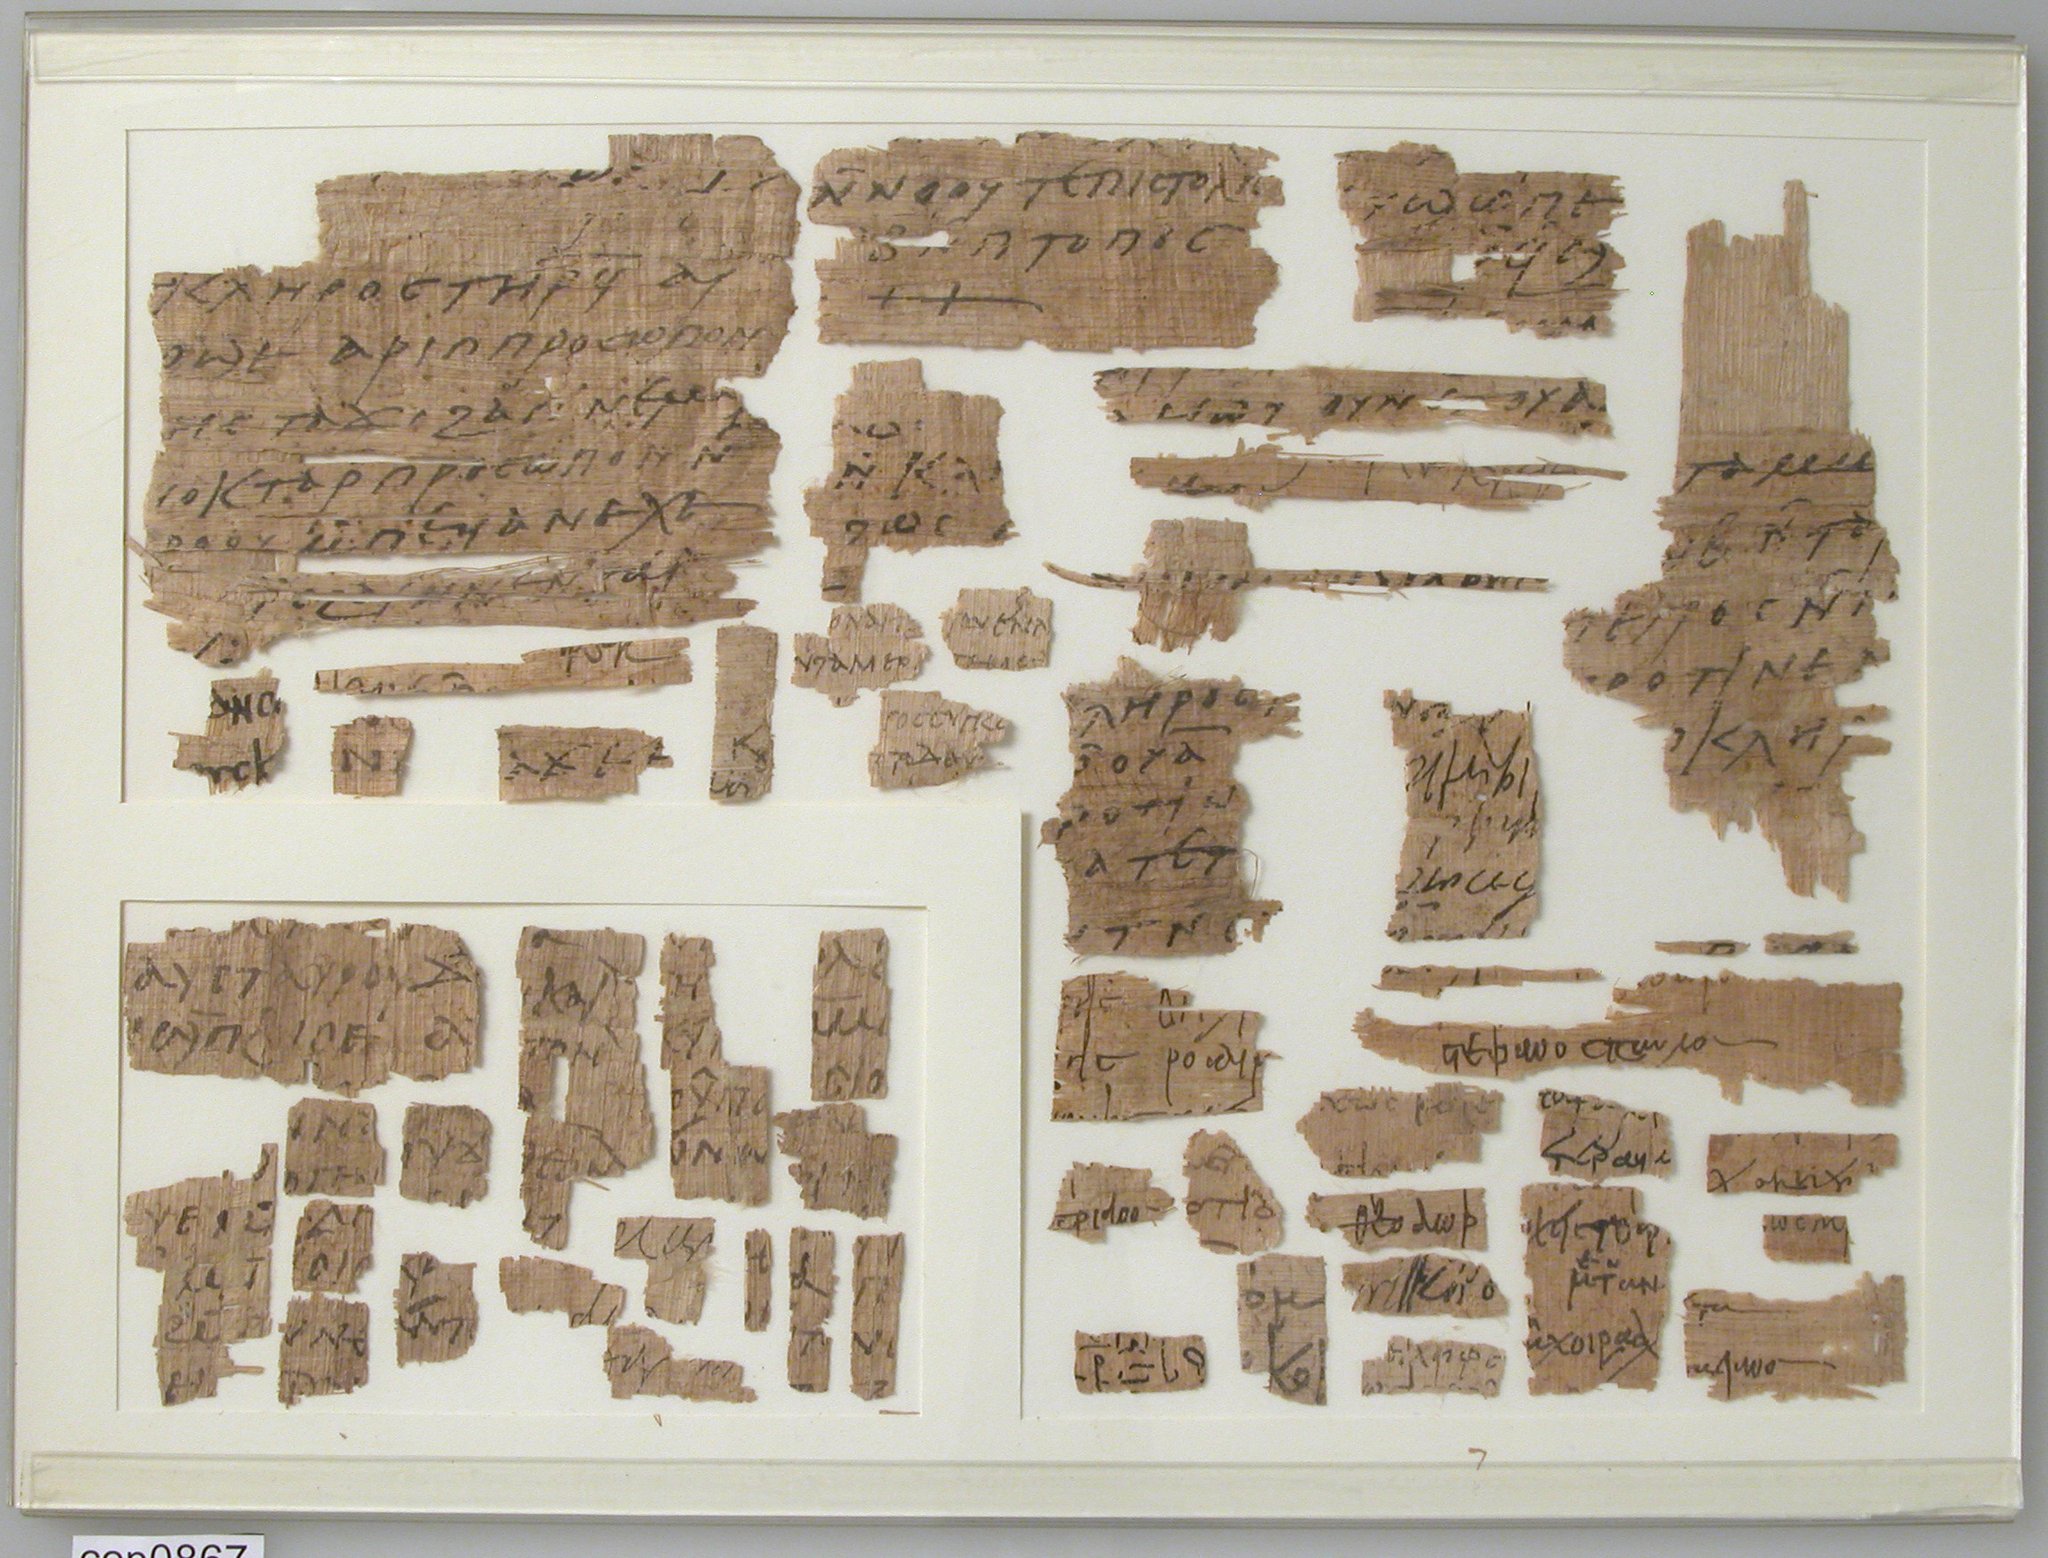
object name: fragment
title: Papyri Fragments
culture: coptic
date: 601-700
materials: ink, papyrus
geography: egypt